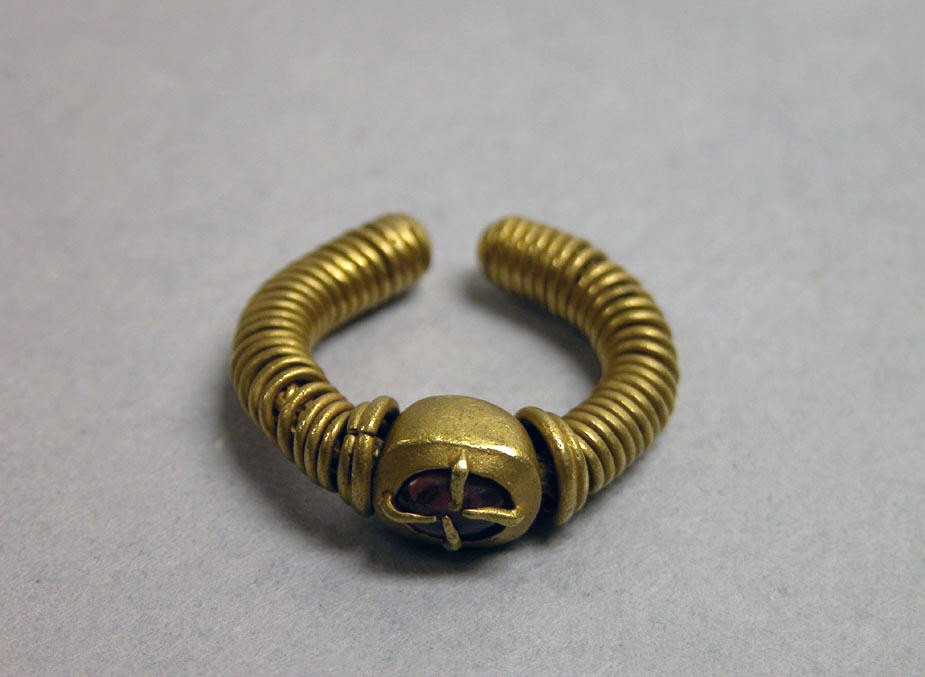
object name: ring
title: Ring with Red Stone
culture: indonesian, javanese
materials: gold, stone